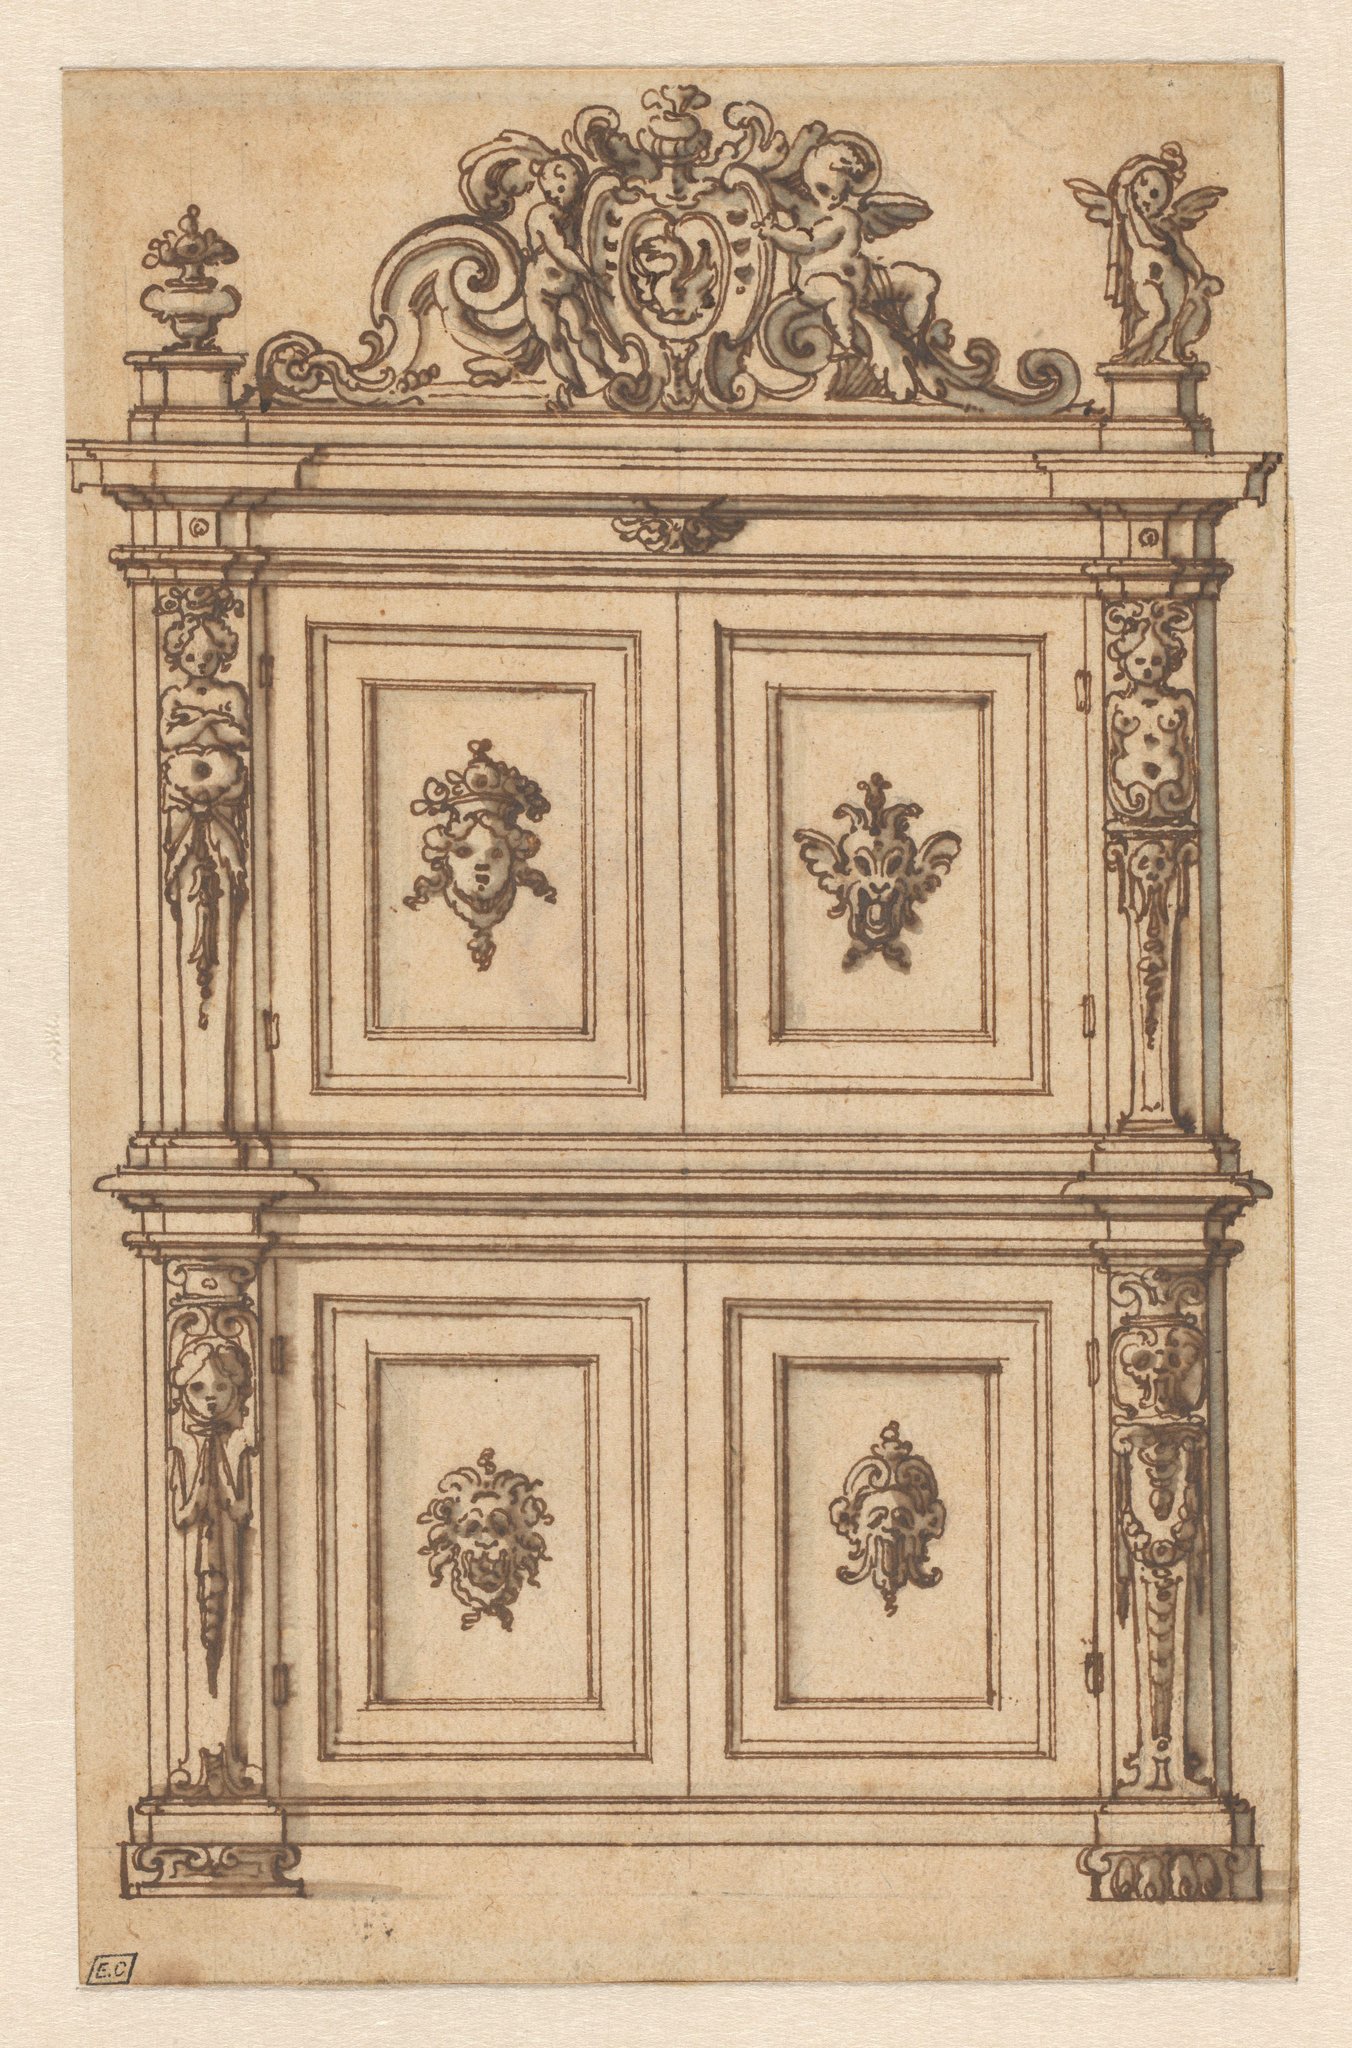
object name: drawing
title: Ontwerp voor een vierdeurskast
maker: giovanni battista montano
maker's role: draughtsman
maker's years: 1534-1621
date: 1580-1600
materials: graphite, ink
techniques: brush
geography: rome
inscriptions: collector's mark: ‘E.C in rechthoek, voor E. Calando, Parijs, tweede helft 19de eeuw’ Lugt 837, coat of arms: ‘wapen met een zwaan’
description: Met alternatiefoplossingen voor de paneelvullingen, de gebeeldhouwde stijlen, de bekroning en de poten.